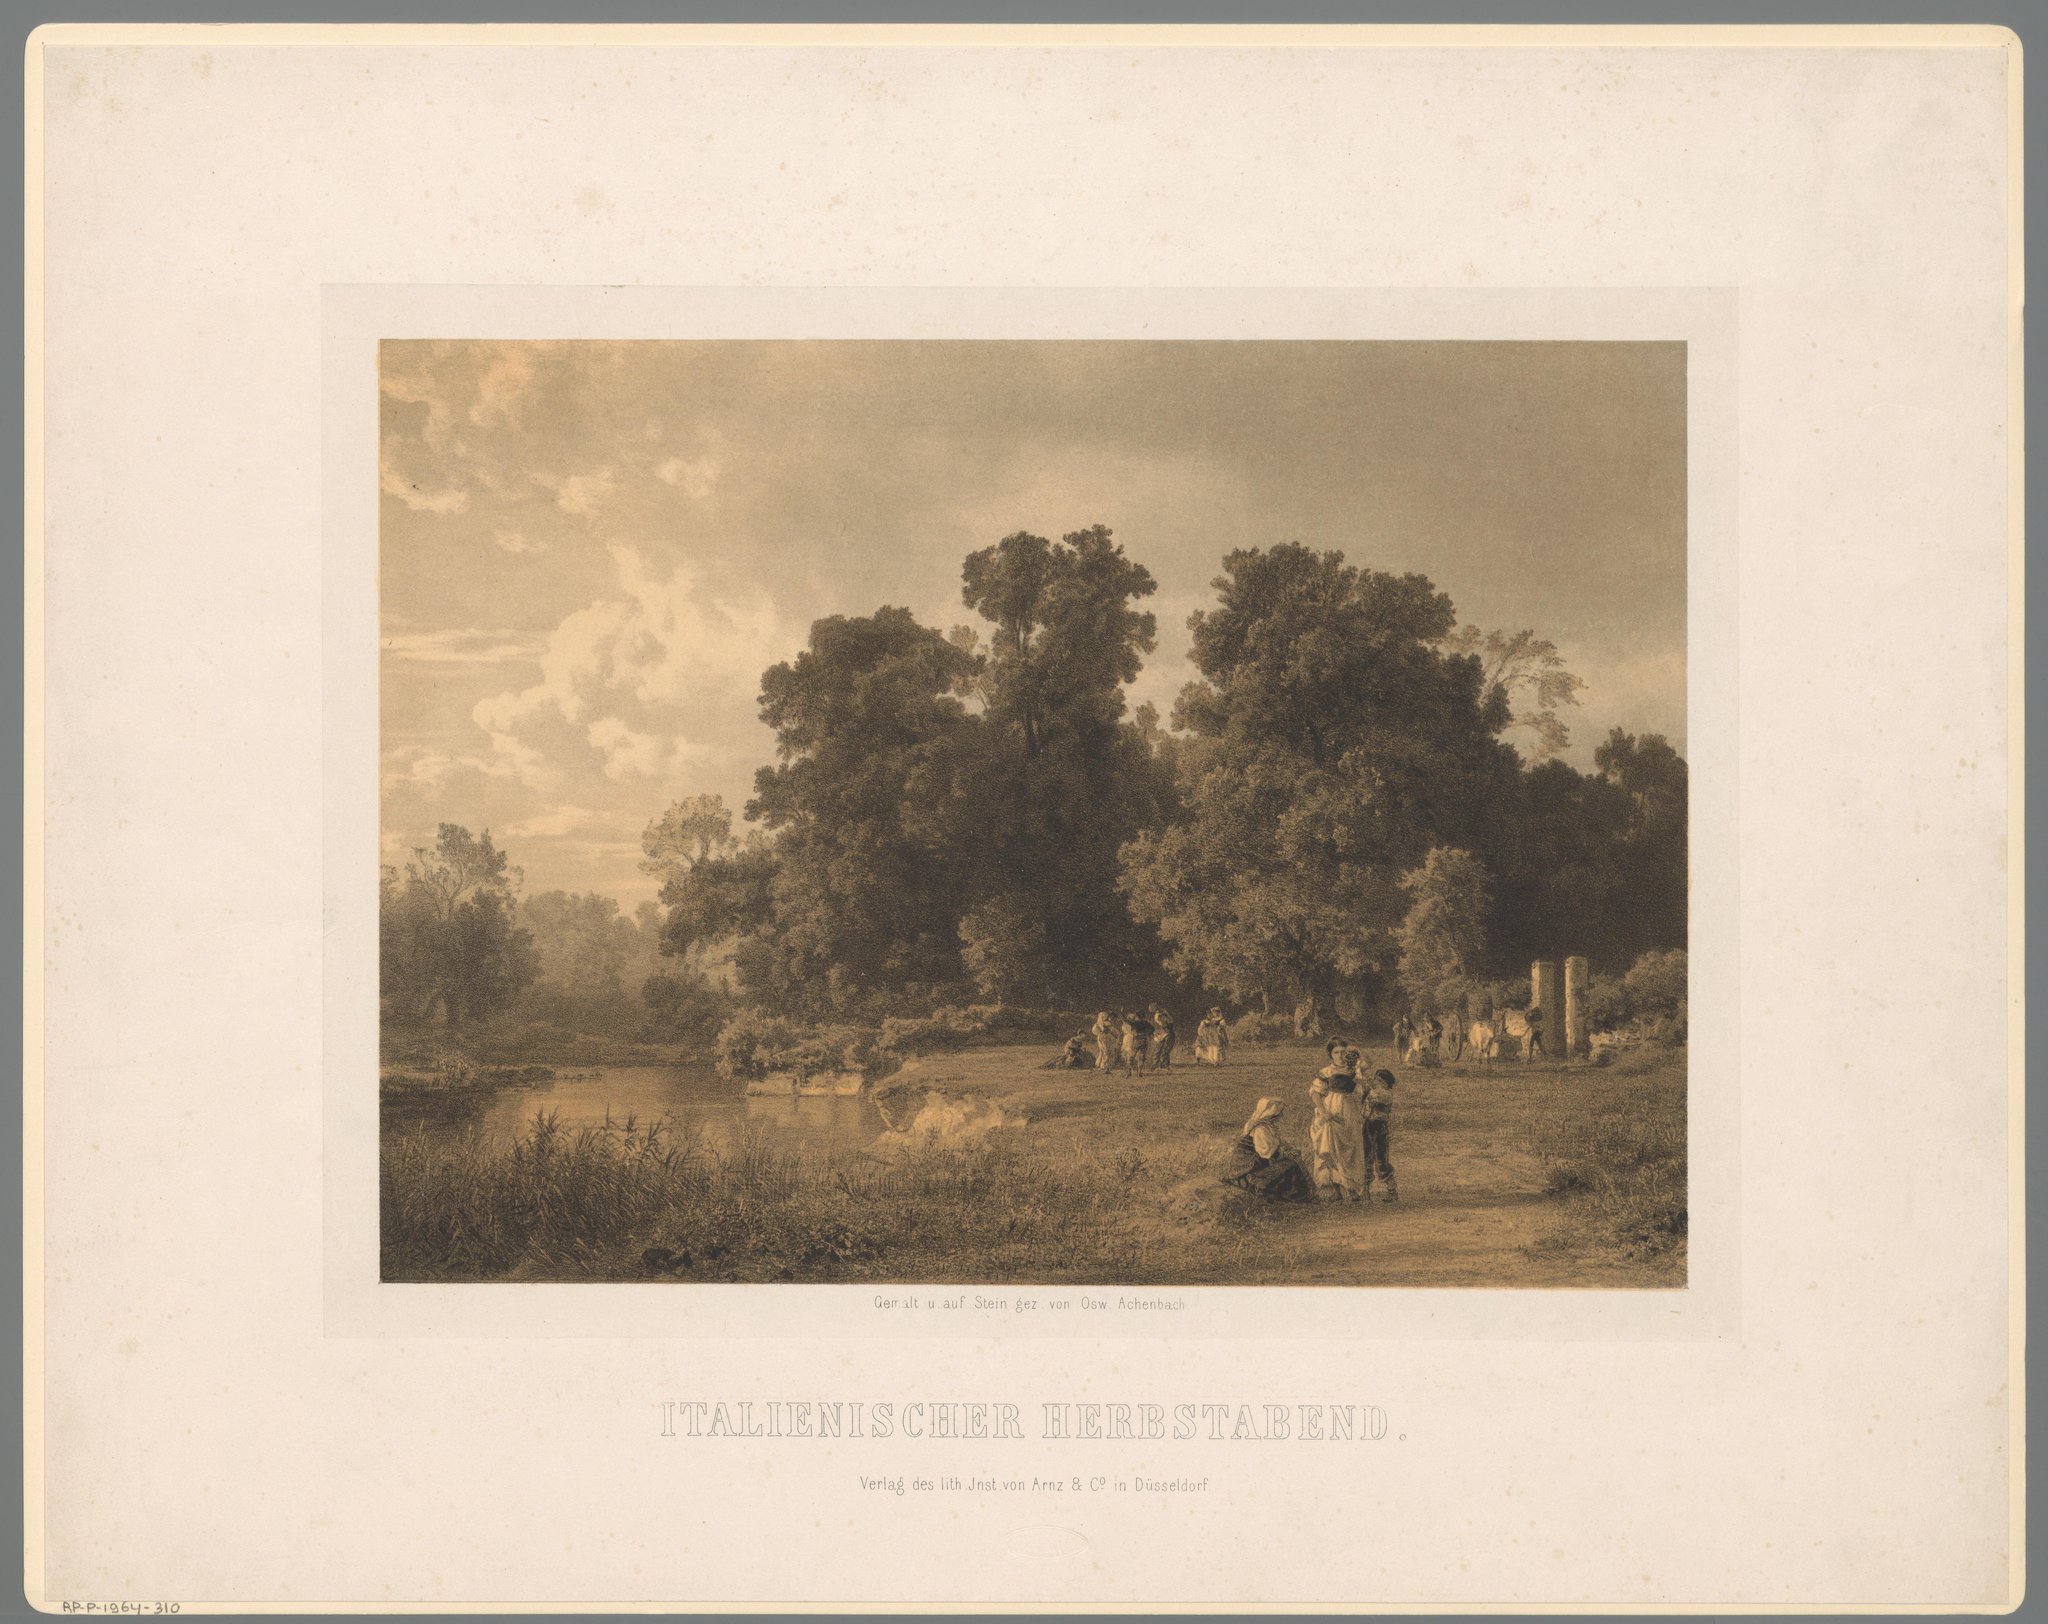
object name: print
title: Landschap met figuren bij een rivier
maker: oswald achenbach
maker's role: print maker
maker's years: 1827-1905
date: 1855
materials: paper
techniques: tone lithography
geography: dusseldorf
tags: landscapes with waters, waterscapes, seascapes (in the temperate zone), group dancing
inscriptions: collector's mark: Lugt 2228, check stamp: ‘Lithographisches Institut Arnz & Co in Dusseldorf’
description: Volgens Nagler is deze prent verschenen in de niet nader bekende publicatie: Kaufmann, A. Kunst und Literatur. Düsseldorf, 1855.